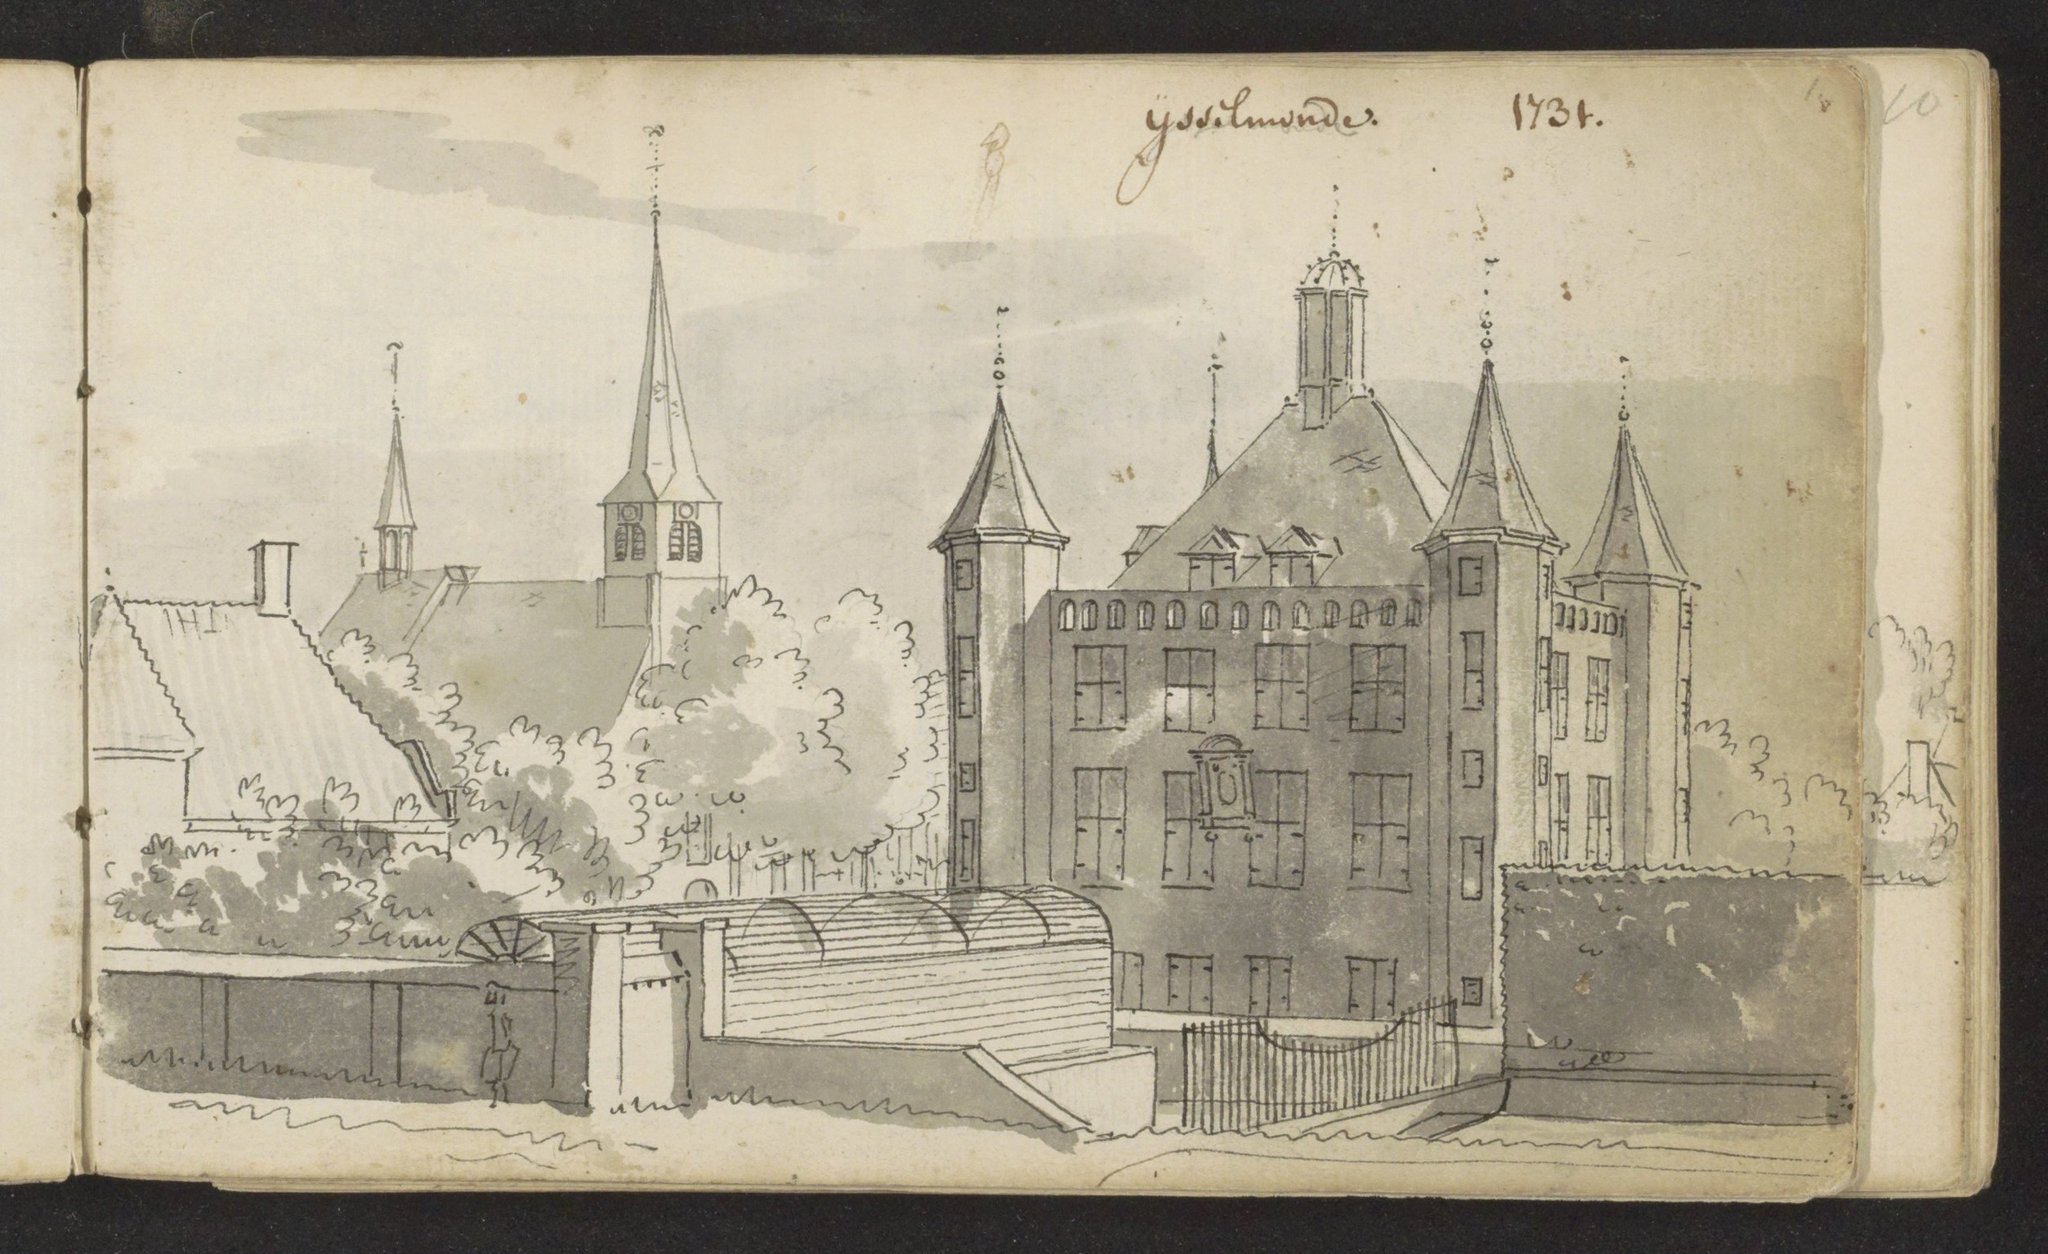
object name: sketchbook leaf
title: Kasteel IJsselmonde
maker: abraham de haen (ii)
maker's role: draughtsman, print maker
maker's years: 1707-1748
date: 1731-1732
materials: ink, paper, pencil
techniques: brush, pen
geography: ijsselmonde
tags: castle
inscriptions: date and inscription: ‘IJsselmonde. 1731.’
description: Blad 1 recto uit een schetsboek met 78 bladen.